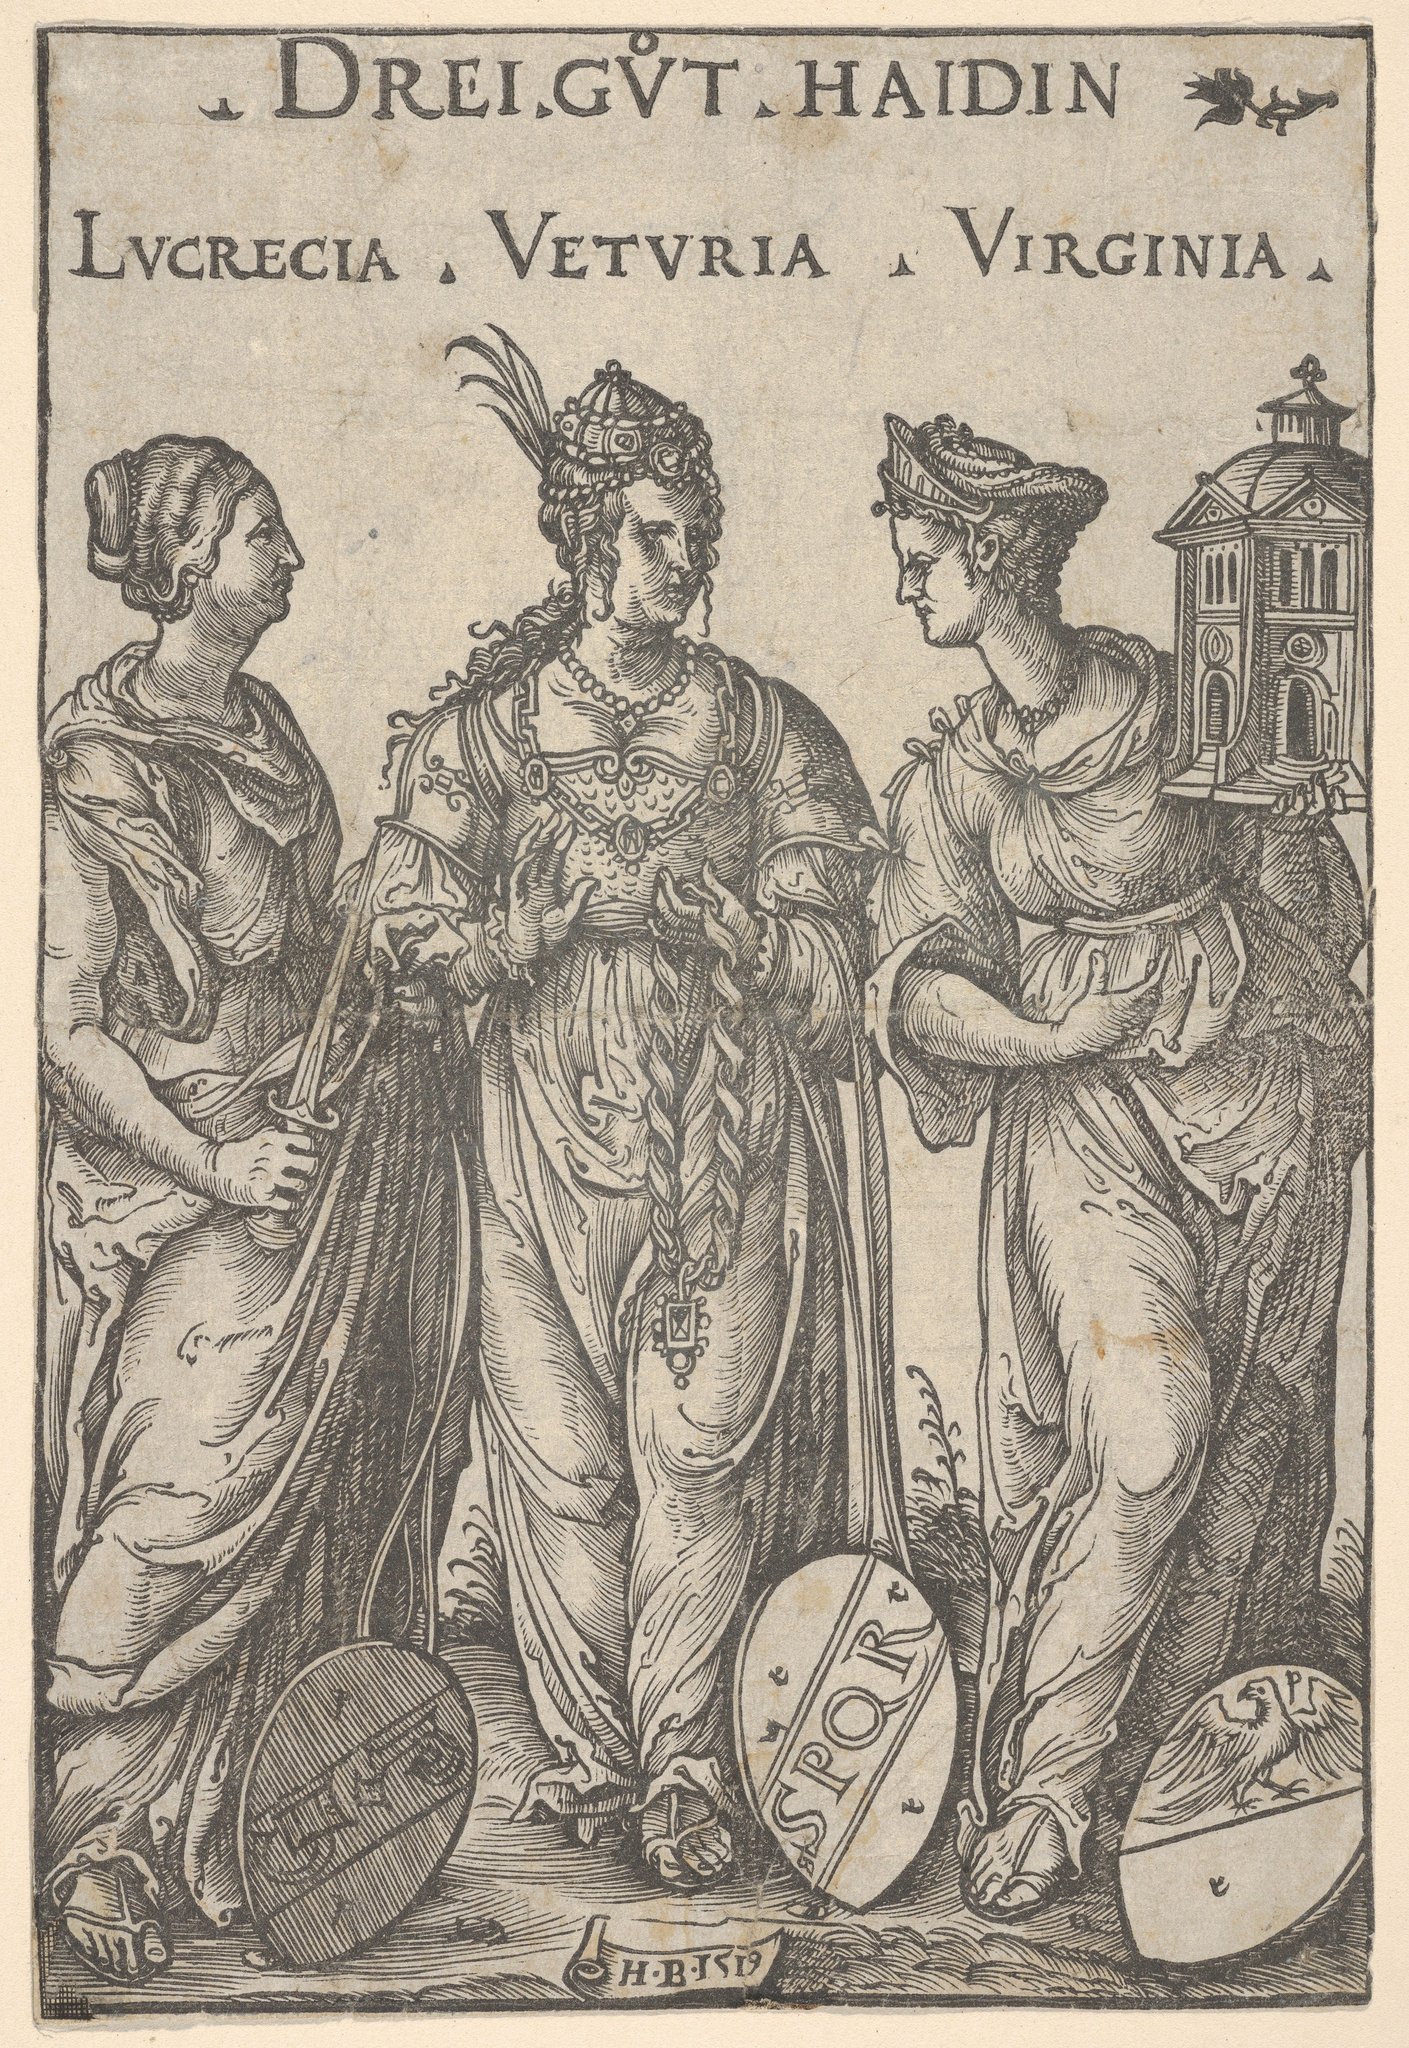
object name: print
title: The Three Heathen Heroines (Drei Gut Haidin), from "Heroes and Heroines"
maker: hans burgkmair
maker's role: artist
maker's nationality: german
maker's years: 1473-1531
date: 1519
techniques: woodcut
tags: swords,women,coat of arms